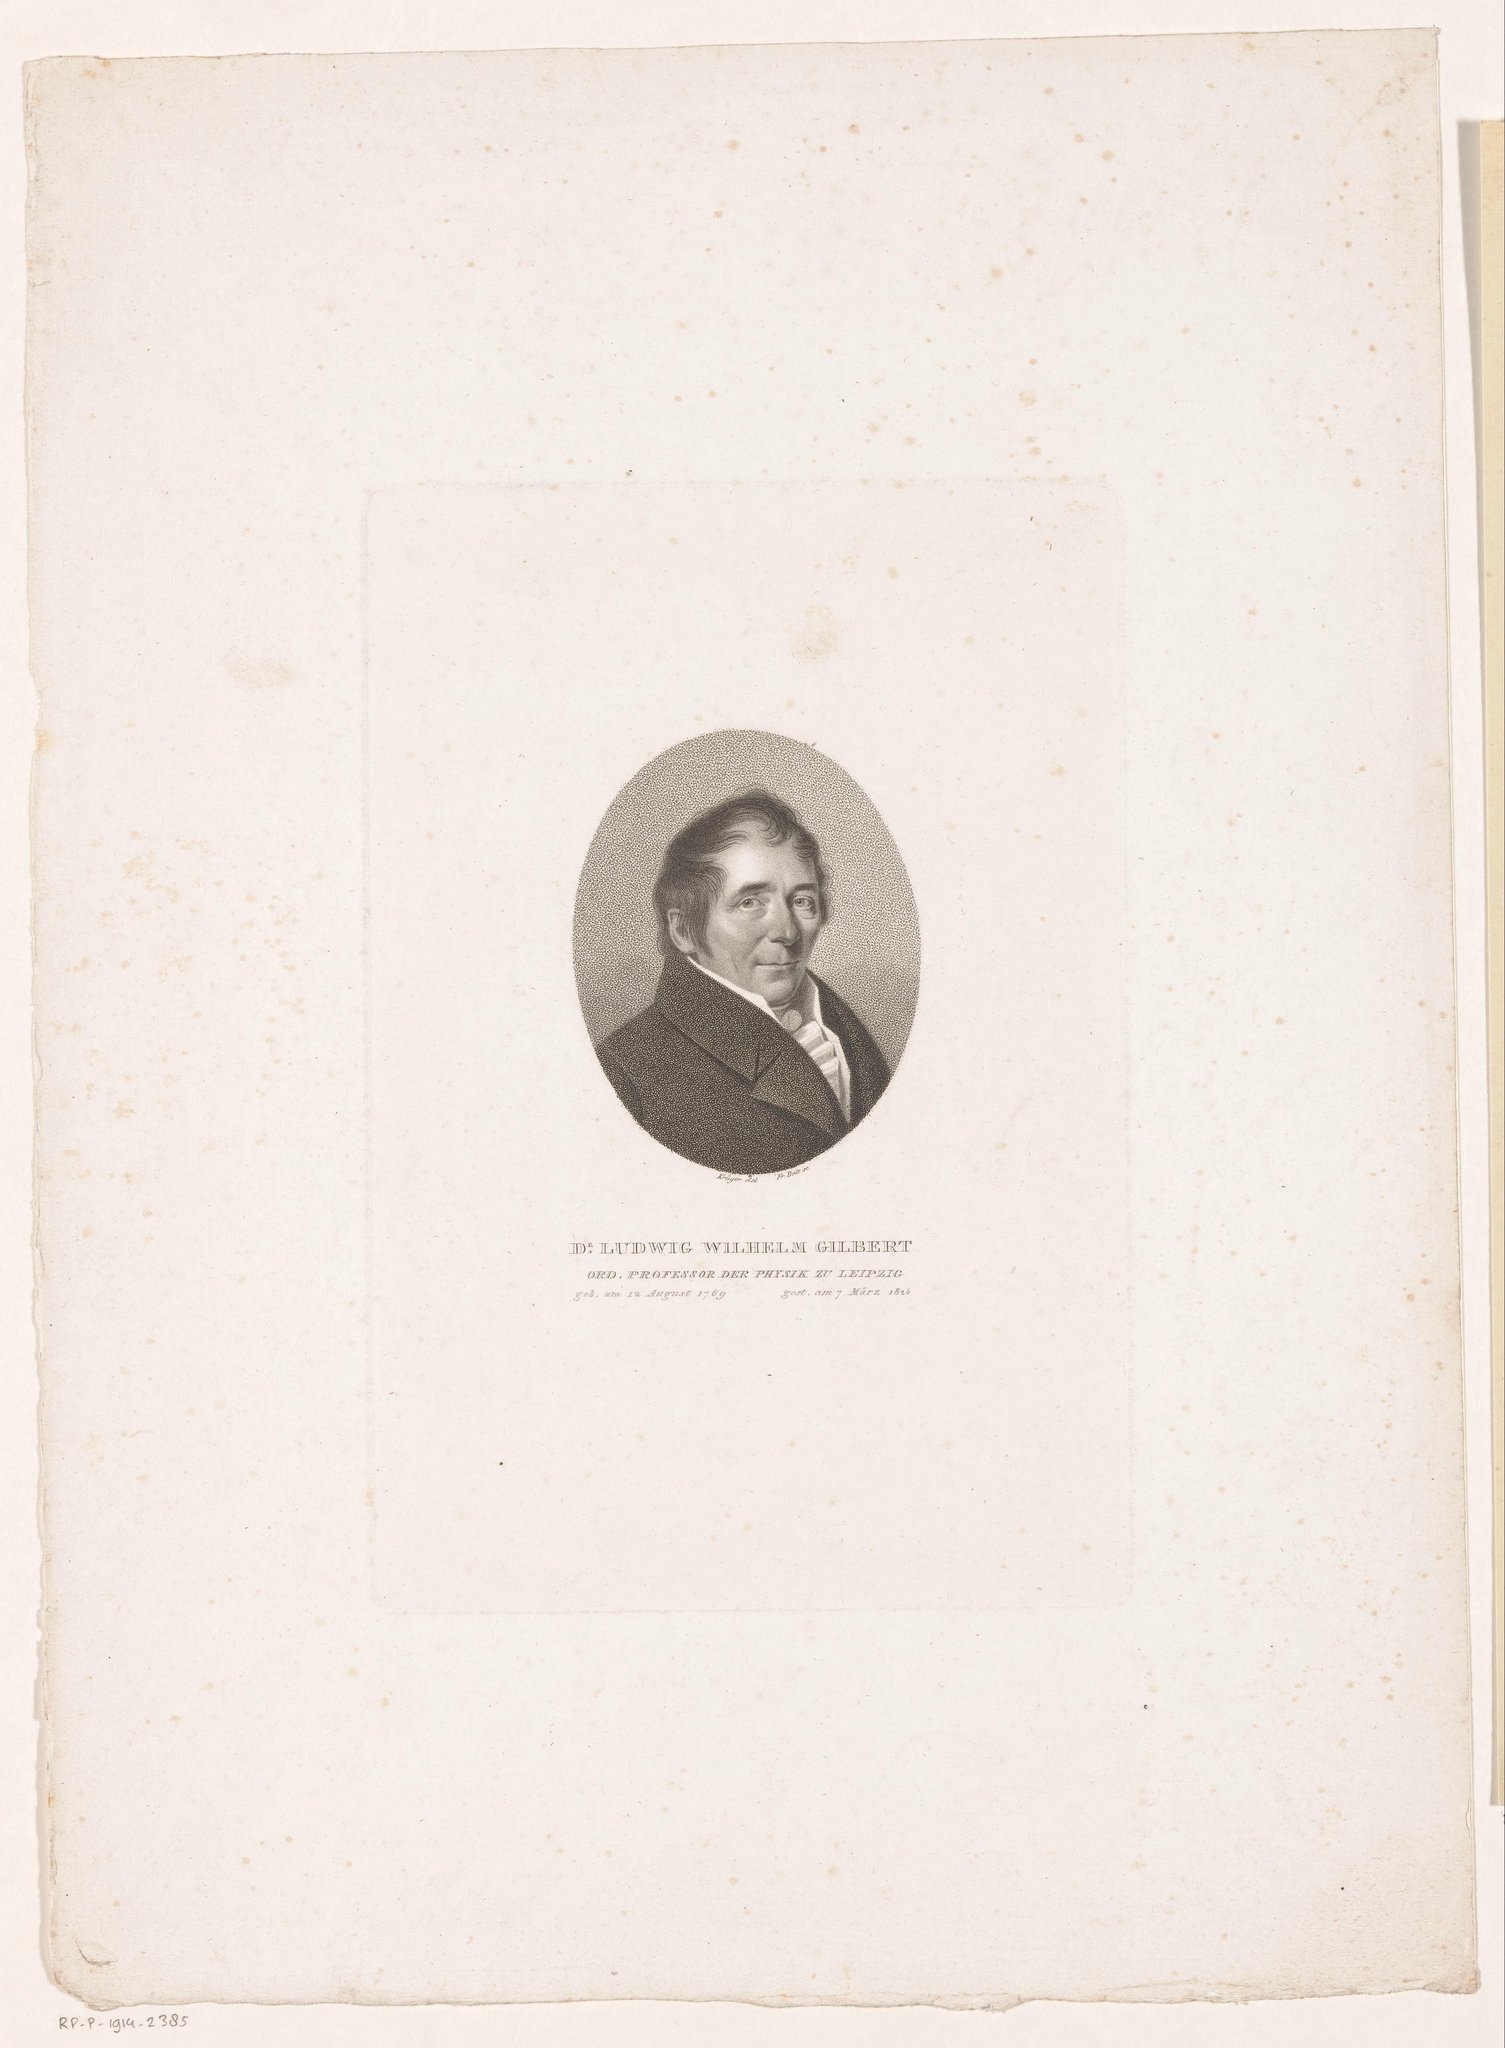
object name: print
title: Portret van Ludwig Wilhelm Gilbert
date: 1824-1836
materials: paper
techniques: stippling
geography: berlin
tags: physicist, historical persons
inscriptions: collector's mark: Lugt 2228